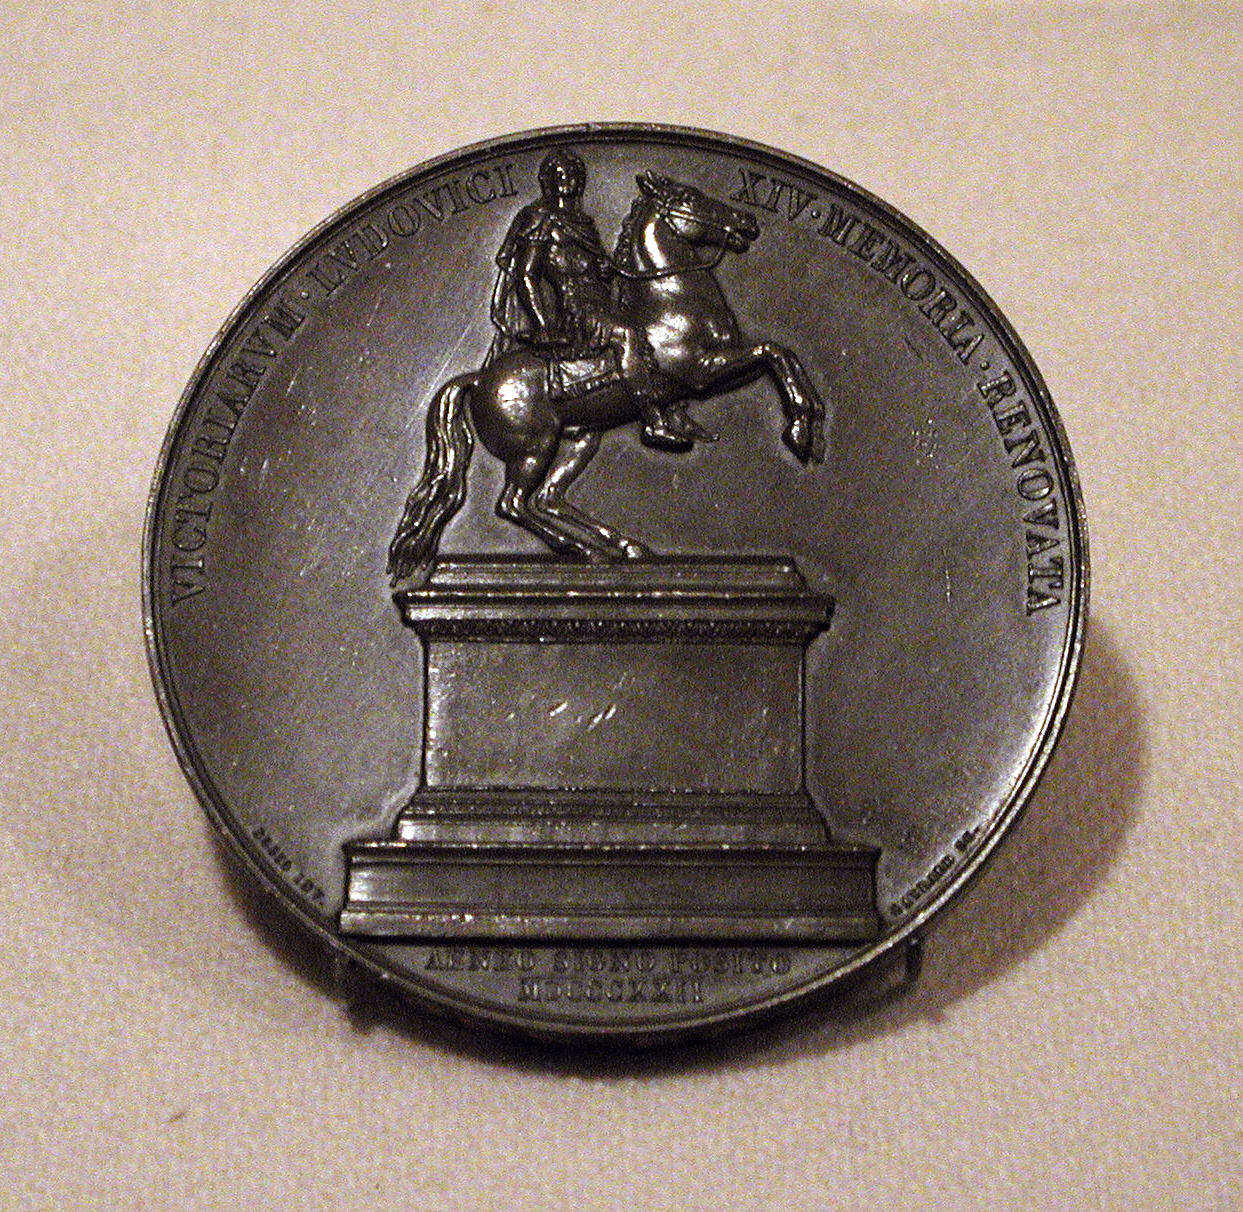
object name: medal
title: Medal Commemorating the Replacement of the Statue of Louis XIV in the Place des Victoires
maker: raymond gayrard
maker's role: artist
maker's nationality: french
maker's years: 1777-1858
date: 1822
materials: bronze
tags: louis xiv,horses